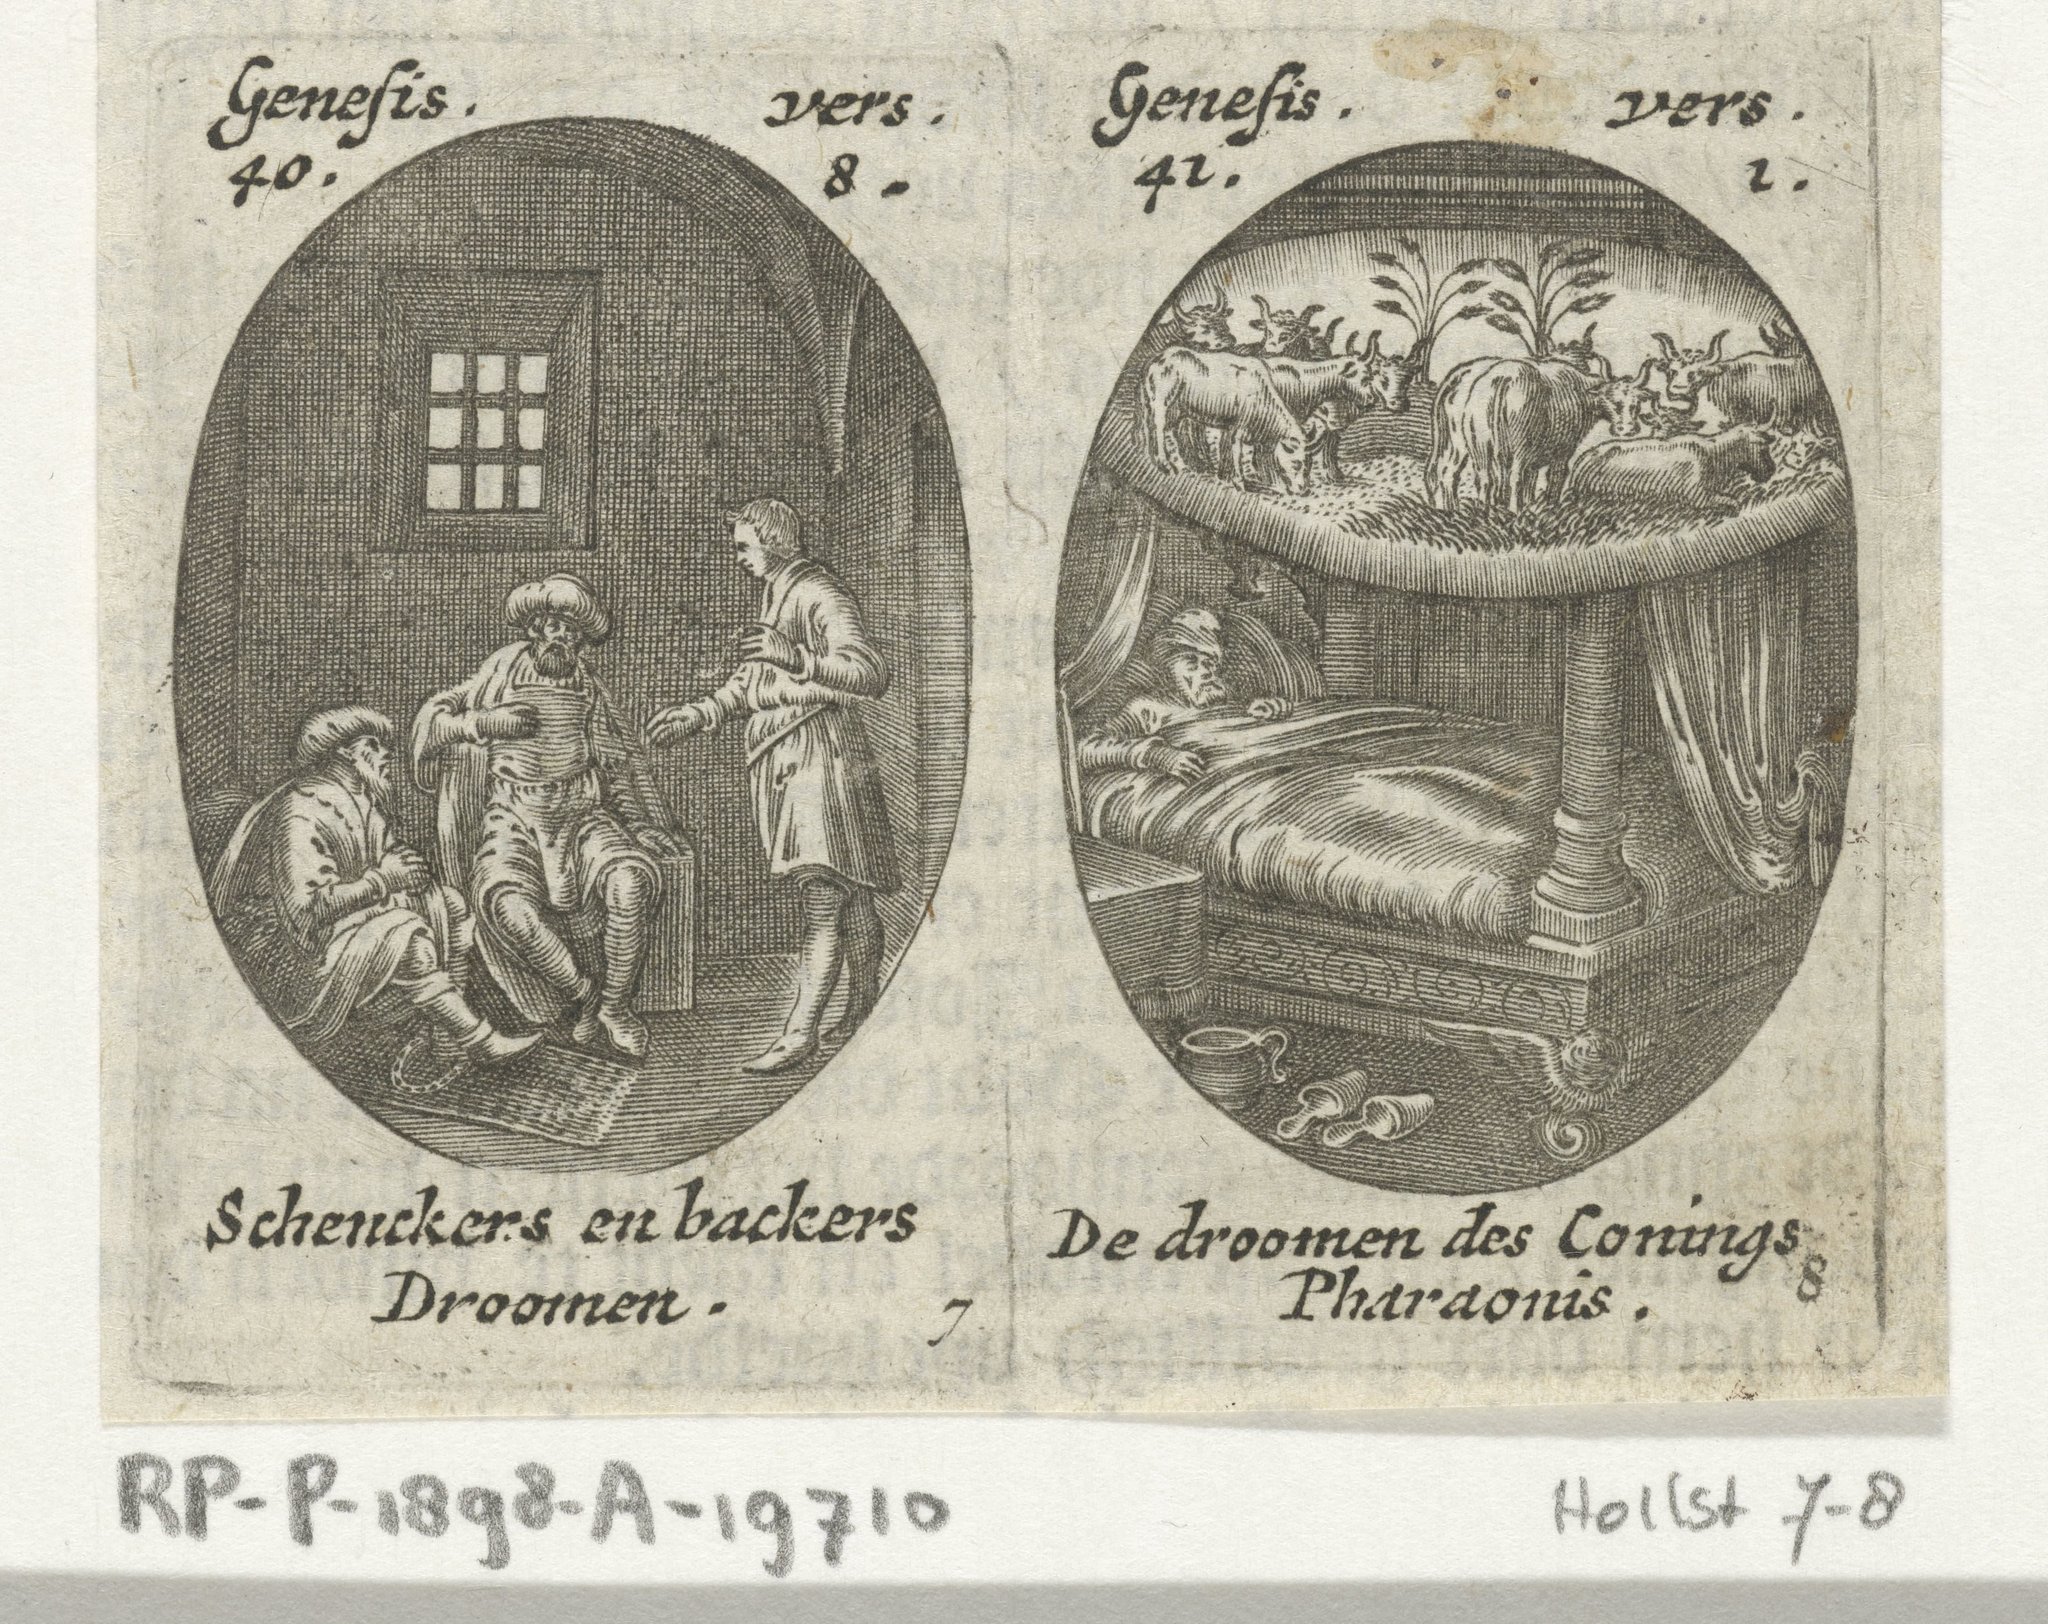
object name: print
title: Jozef legt dromen uit van schenker en bakker / De droom van de farao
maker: hans janssen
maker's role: print maker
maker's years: 1605-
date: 1615-1651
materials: paper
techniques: engraving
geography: amsterdam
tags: joseph interpreting the dreams of the butler and the baker (the two dreams combined), pharaoh's dreams ~ story of joseph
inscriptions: collector's mark: Lugt 2228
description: Twee afdrukken op één blad in ovaal. Links legt Jozef in de gevangenis de dromen van de schenker en de bakker van de koning uit (Gen. 40-8). Rechts de farao slapend in zijn bed. Boven zijn bed staan zeven koeien aan de oever van de Nijl (Gen. 41-1). In de marges onderschrift in het Nederlands. Zevende en achtste prent (7 en 8) uit een serie van twaalf met scènes uit het leven van Jozef.